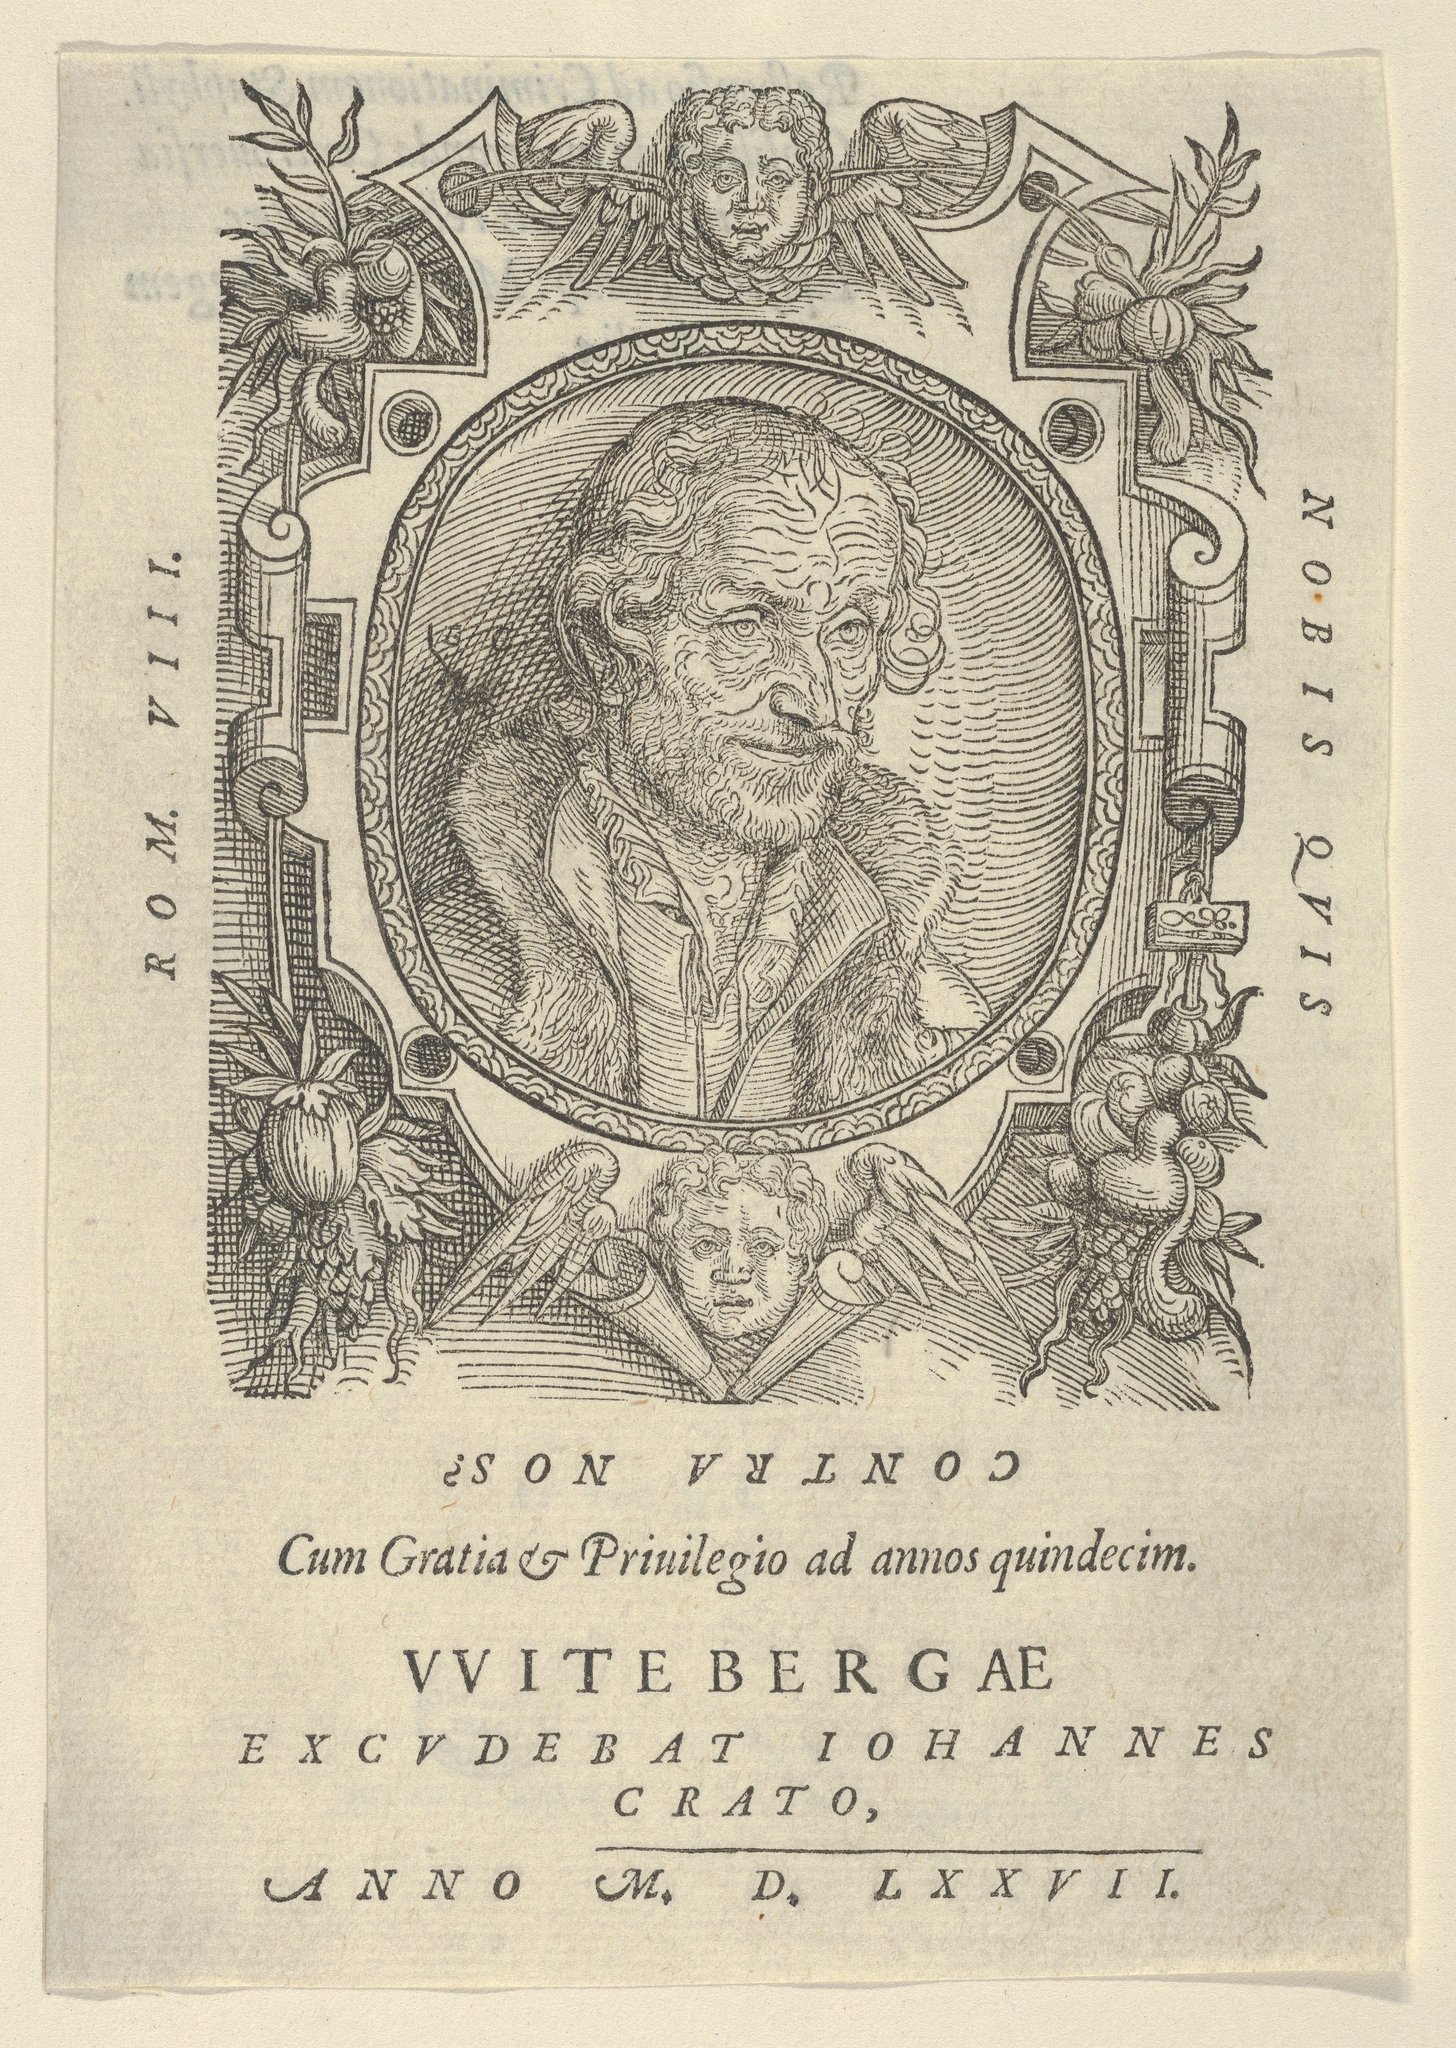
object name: print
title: Philipp Melanchthon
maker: lucas cranach the younger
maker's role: artist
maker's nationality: german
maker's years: 1515-1586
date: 1515-1586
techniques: woodcut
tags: men,portraits